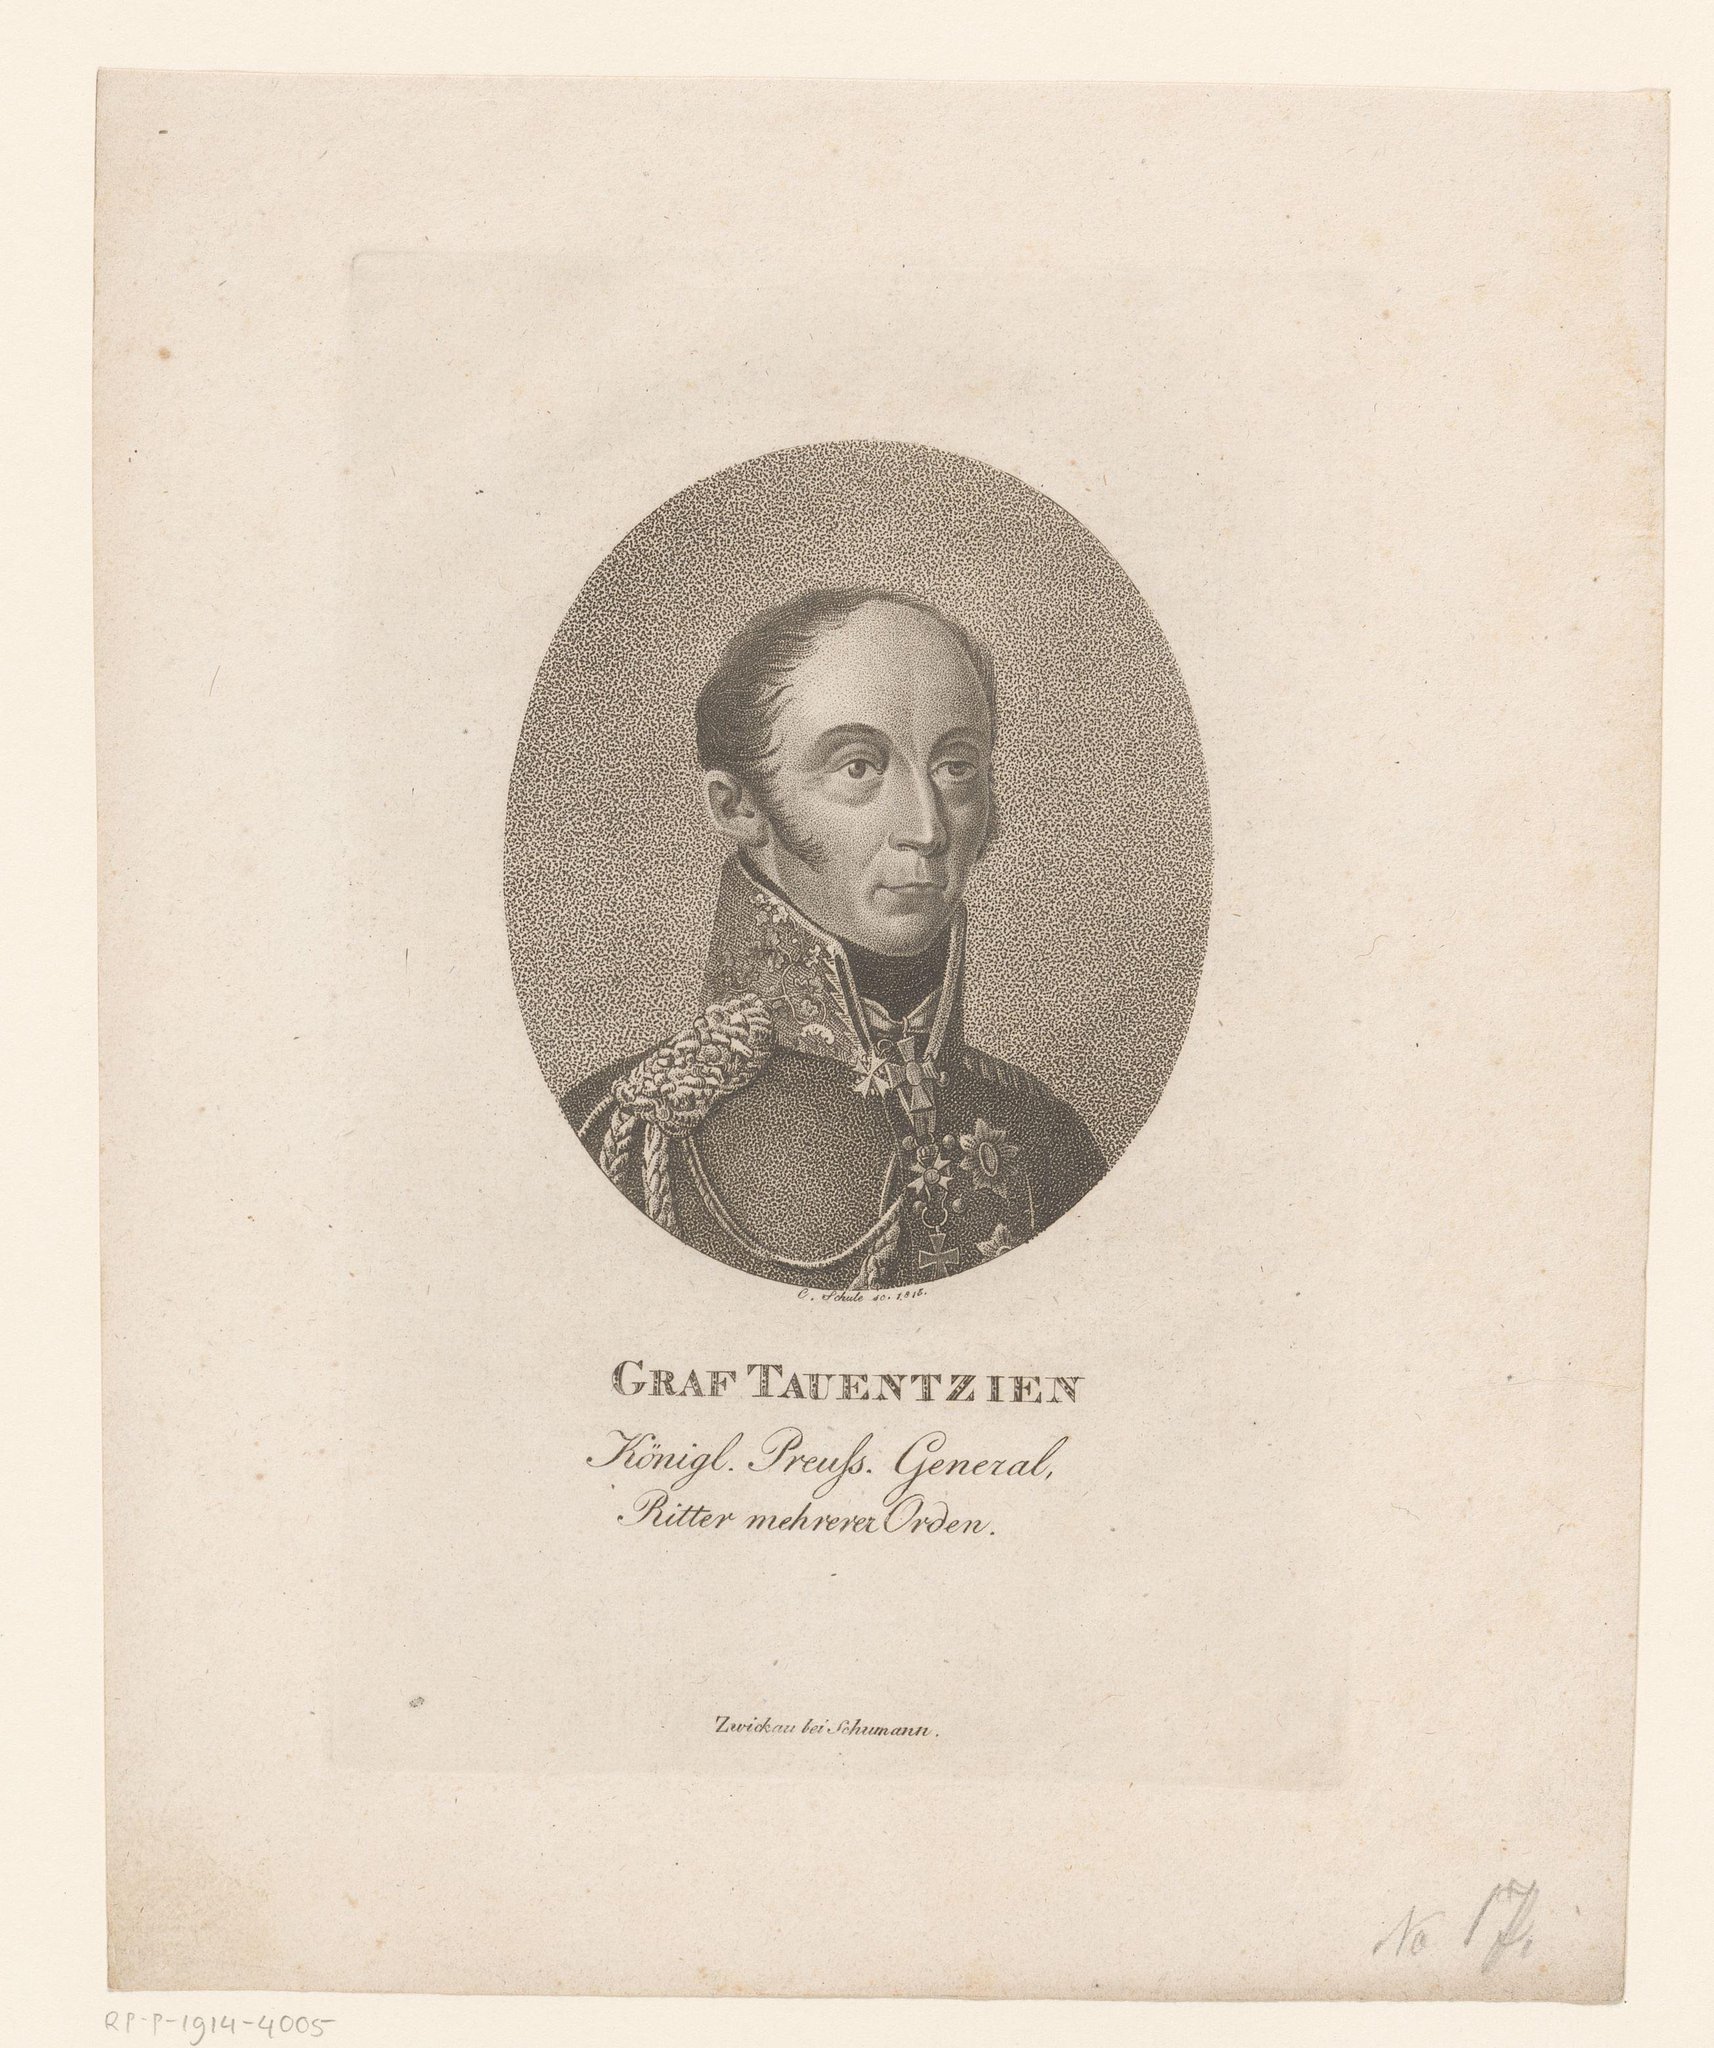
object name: print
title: Graf Tauentzien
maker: christian schule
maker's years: 1764-1816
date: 1815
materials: paper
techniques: etching, engraving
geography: zwickau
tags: berlin, commander-in-chief, general, marshal, historical persons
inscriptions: collector's mark: Lugt 2228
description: Portret van Bogislav Friedrich Emanuel Graf Tauentzien von Wittenberg, Pruisische generaal.